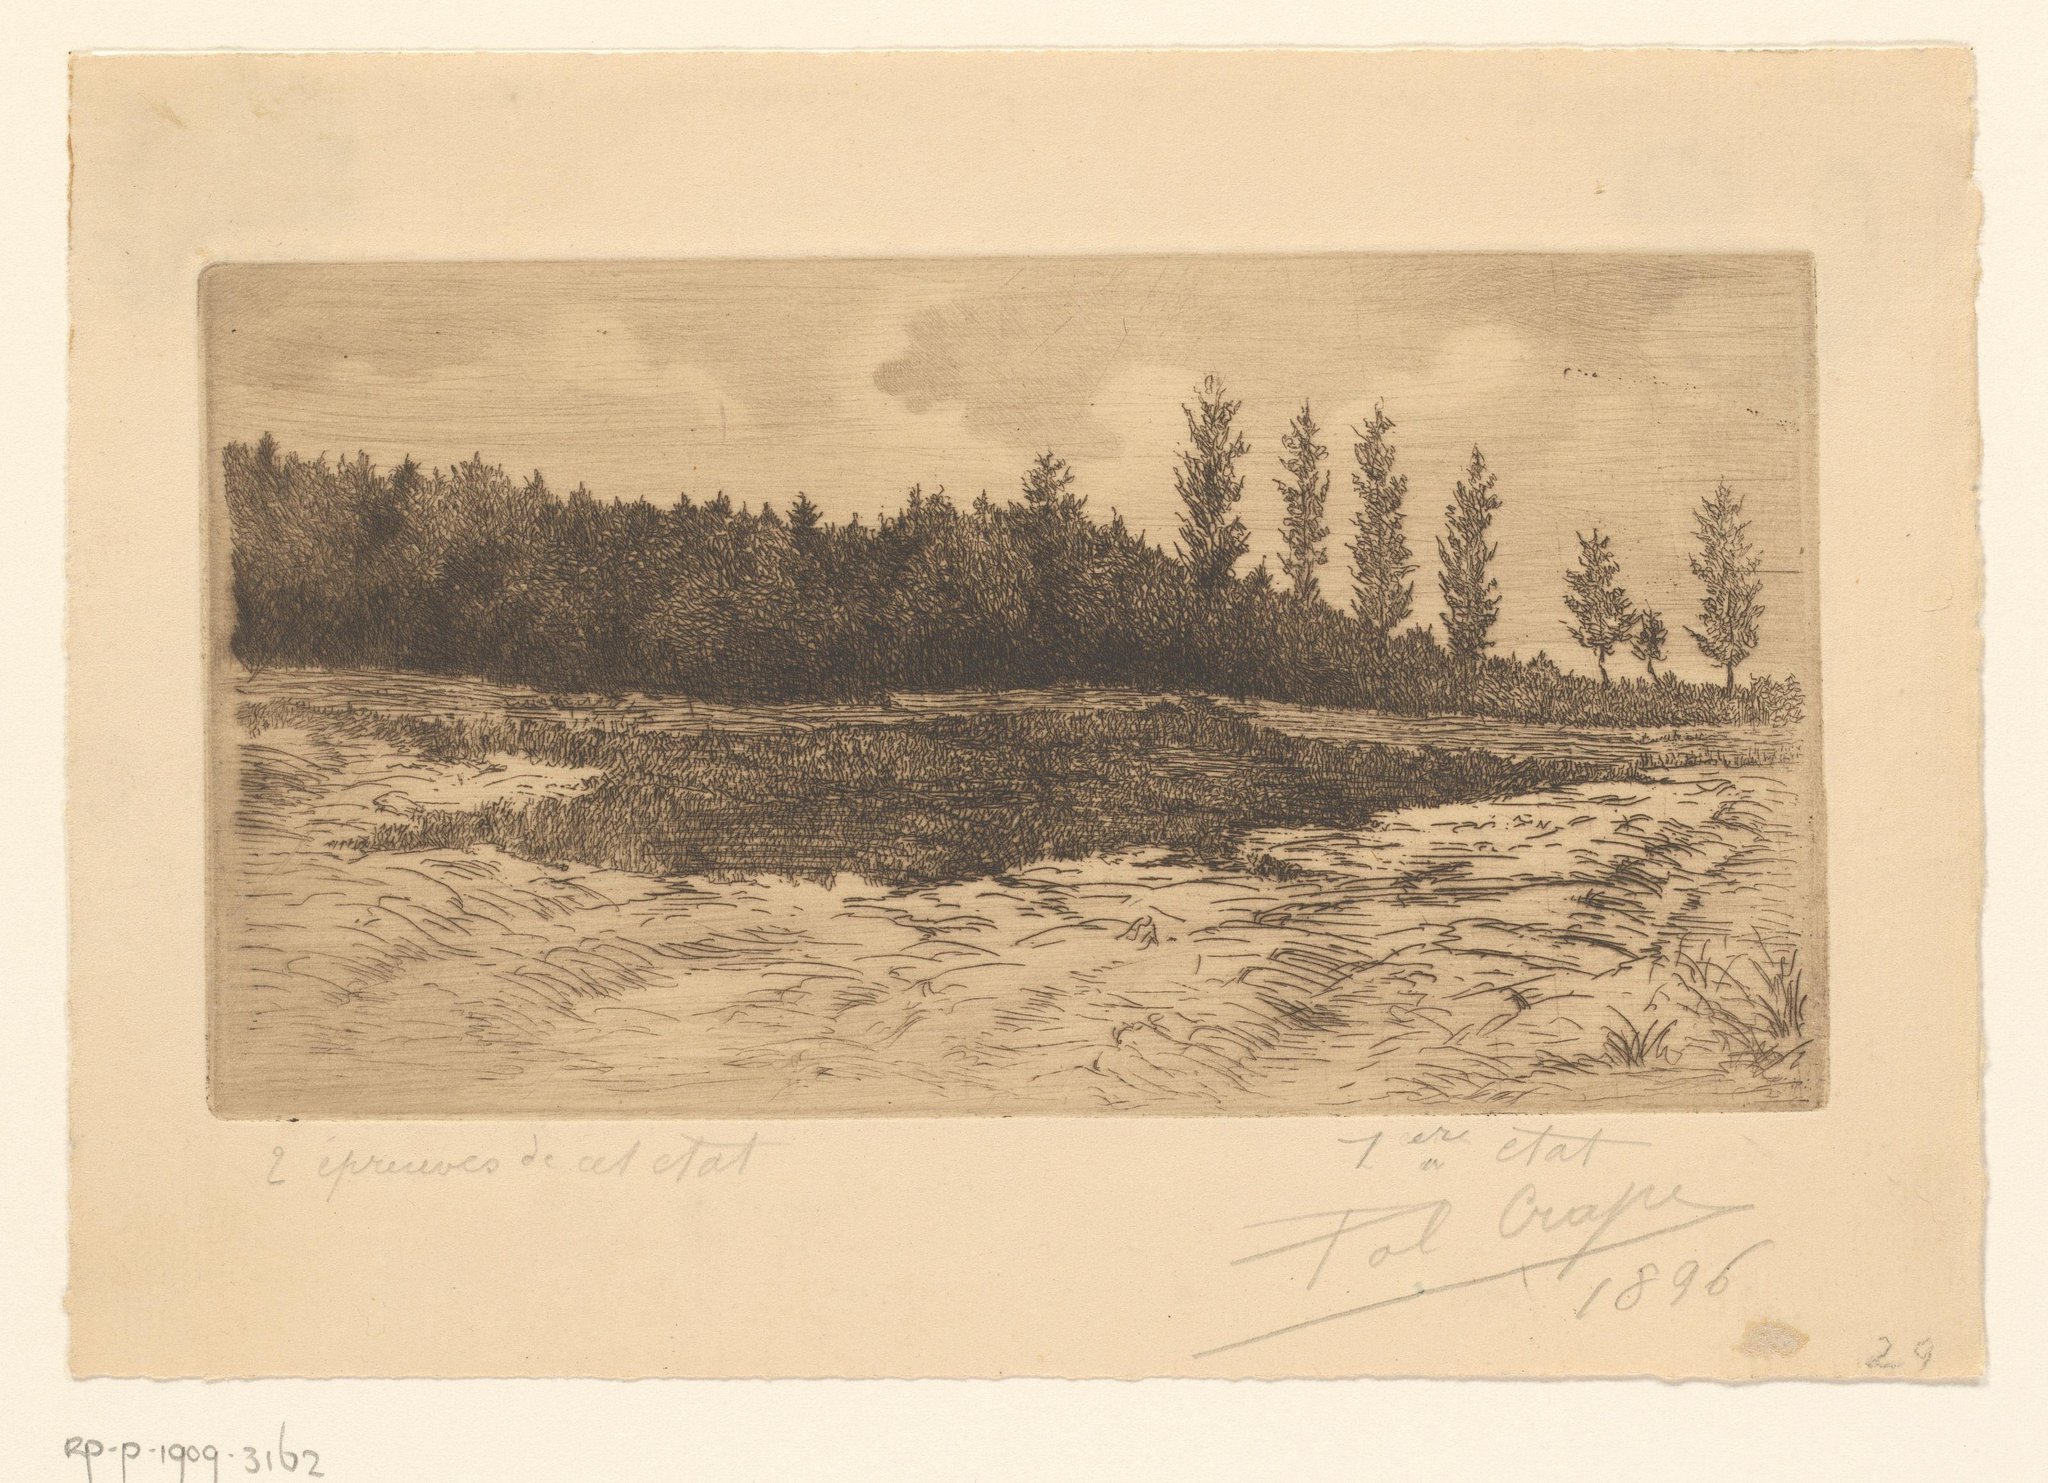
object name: print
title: Heidelandschap bij Ukkel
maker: pol craps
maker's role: print maker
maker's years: 1877-1939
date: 1896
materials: paper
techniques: drypoint, etching, intaglio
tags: forest, wood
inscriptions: collector's mark: Lugt 2228, annotation: ‘2 épreuves de cet etat; 1ere etat’